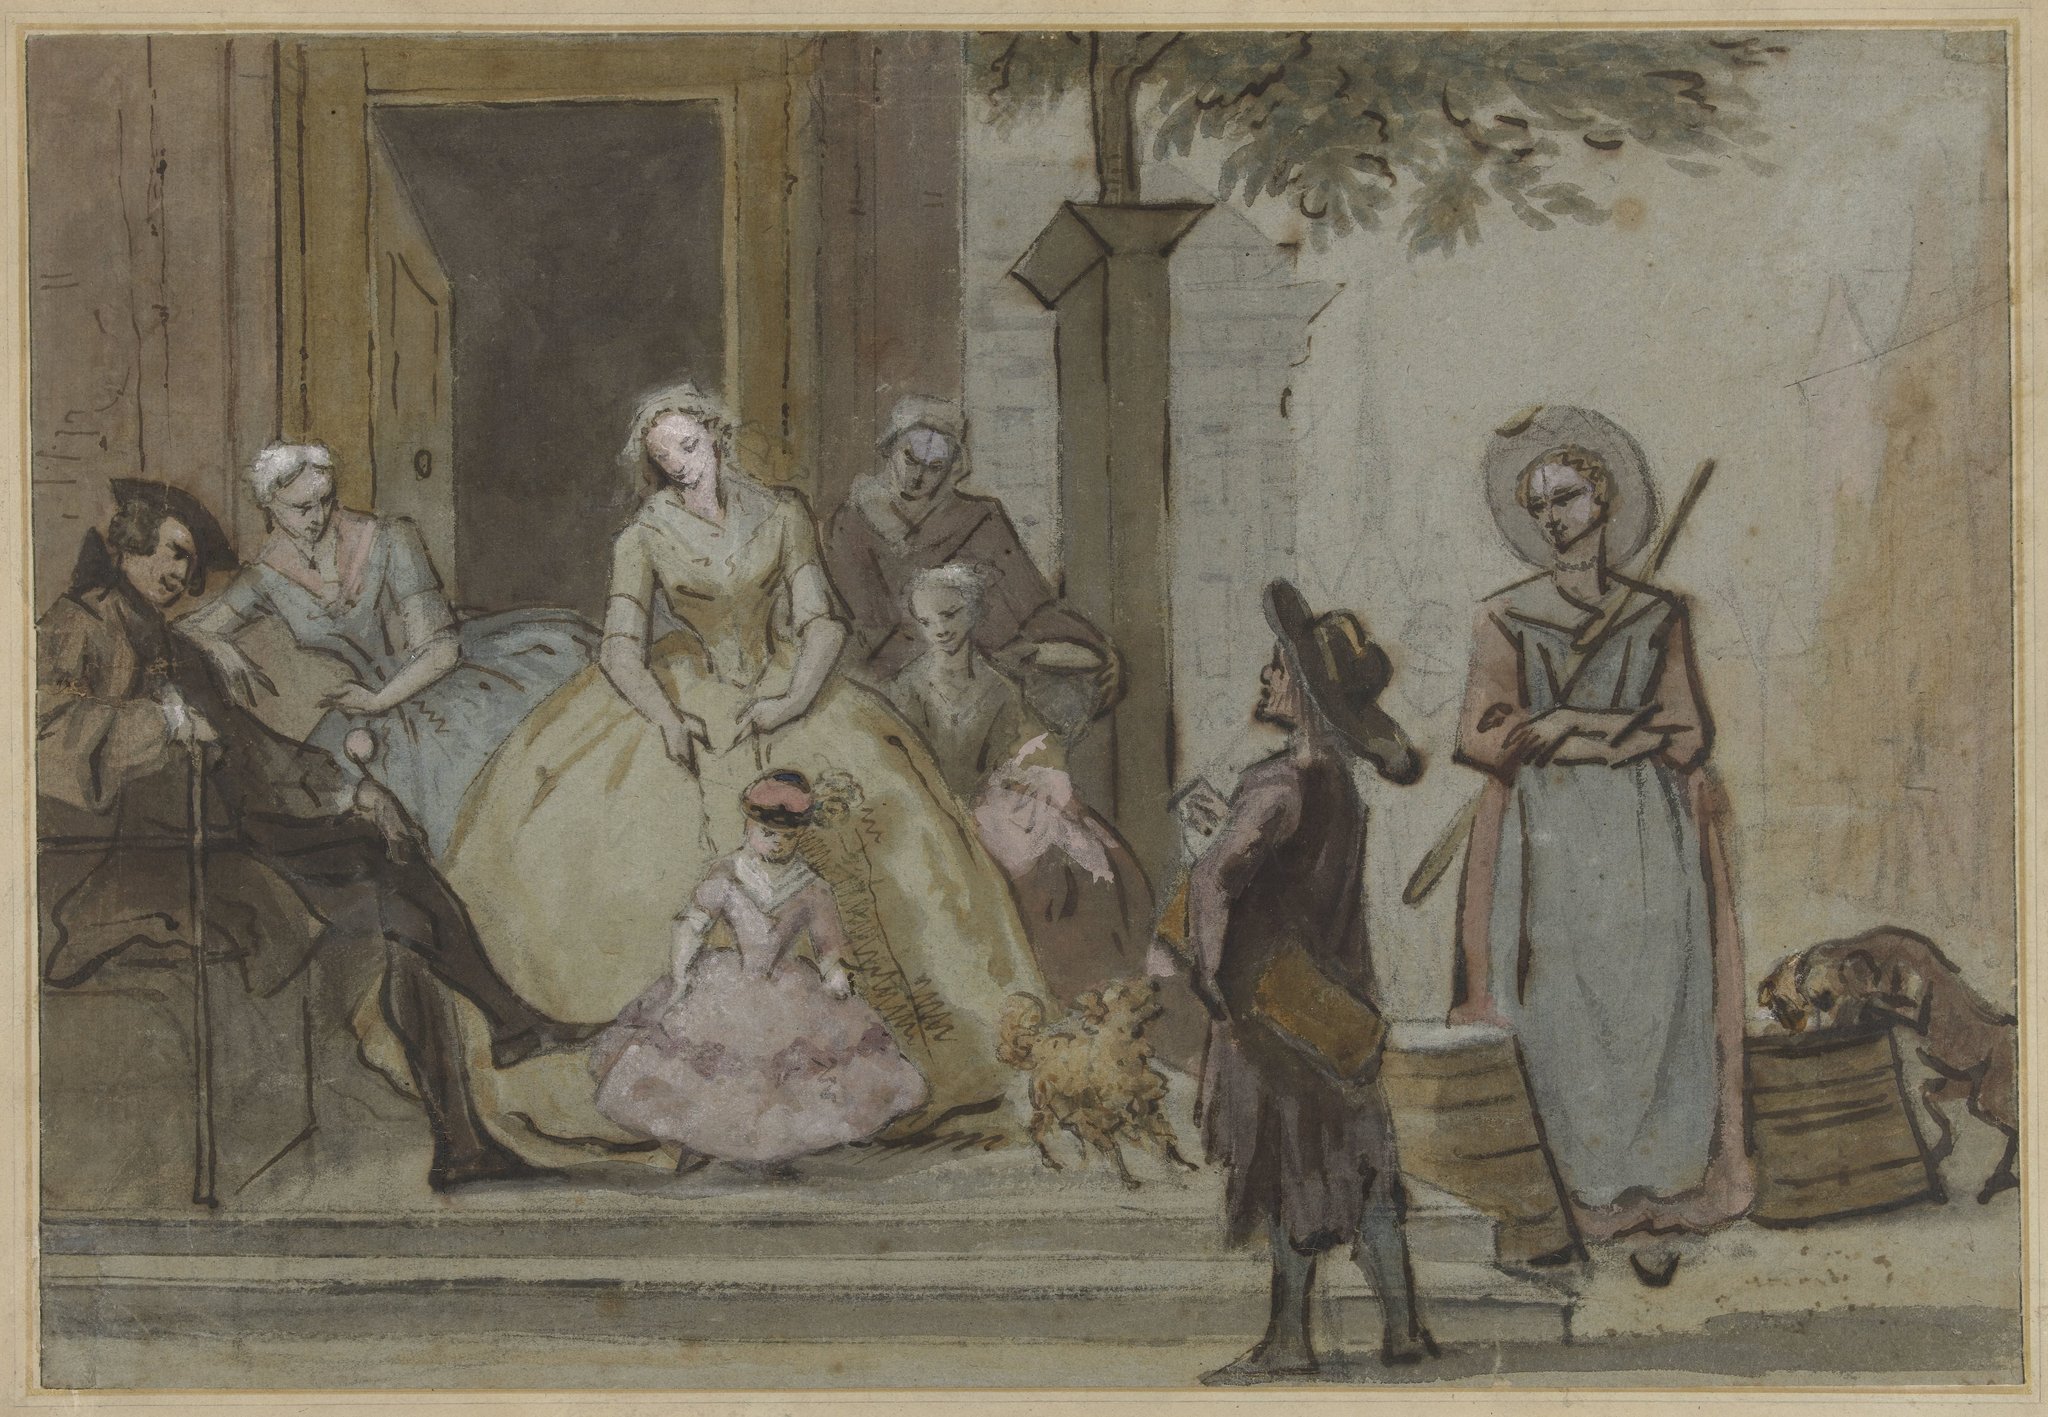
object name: drawing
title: Draailier-speler voor een luisterende familie op de stoep van een stadshuis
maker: cornelis troost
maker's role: draughtsman, painter, print maker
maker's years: 1696-1750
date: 1706-1750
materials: chalk, ink, paper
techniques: brush, pen